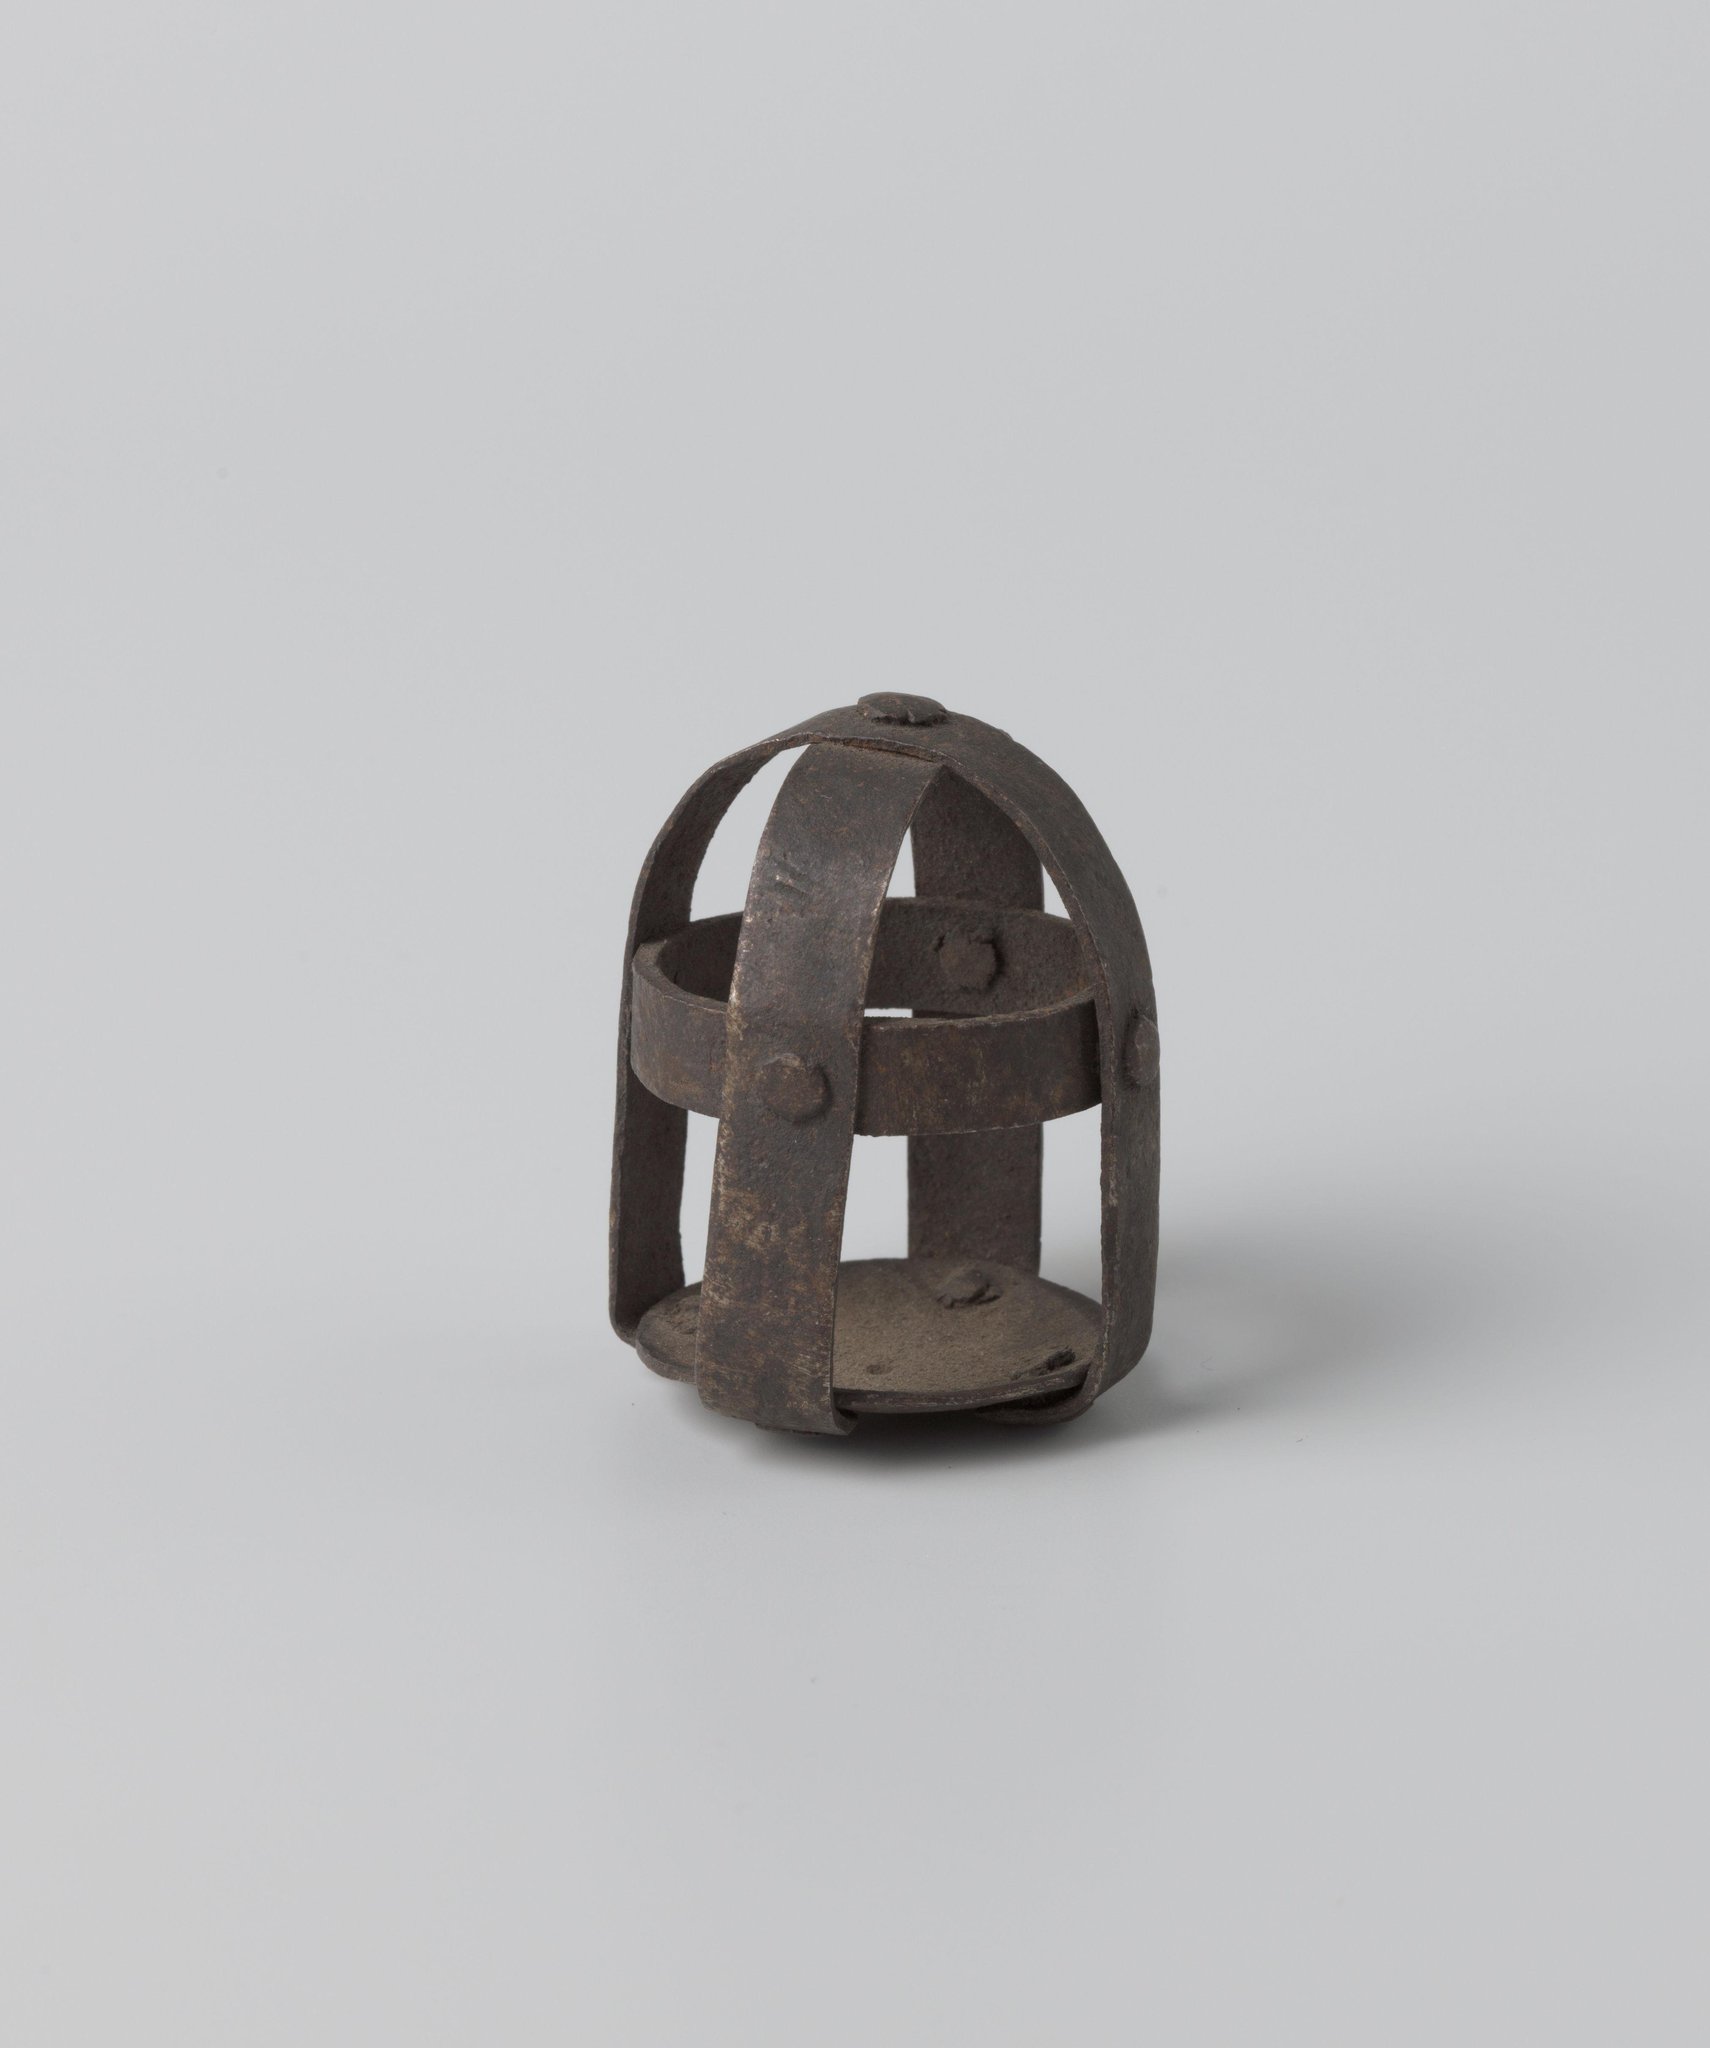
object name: scale model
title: Model van een karkas voor brand- en lichtkogels met lichtkogelmal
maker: Anonymous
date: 1699-1899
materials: iron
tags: west-europa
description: Model van een karkas voor brand- en lichtkogels met lichtkogelmal. [beschrijving overgenomen uit overeenkomst AHM, 1977]